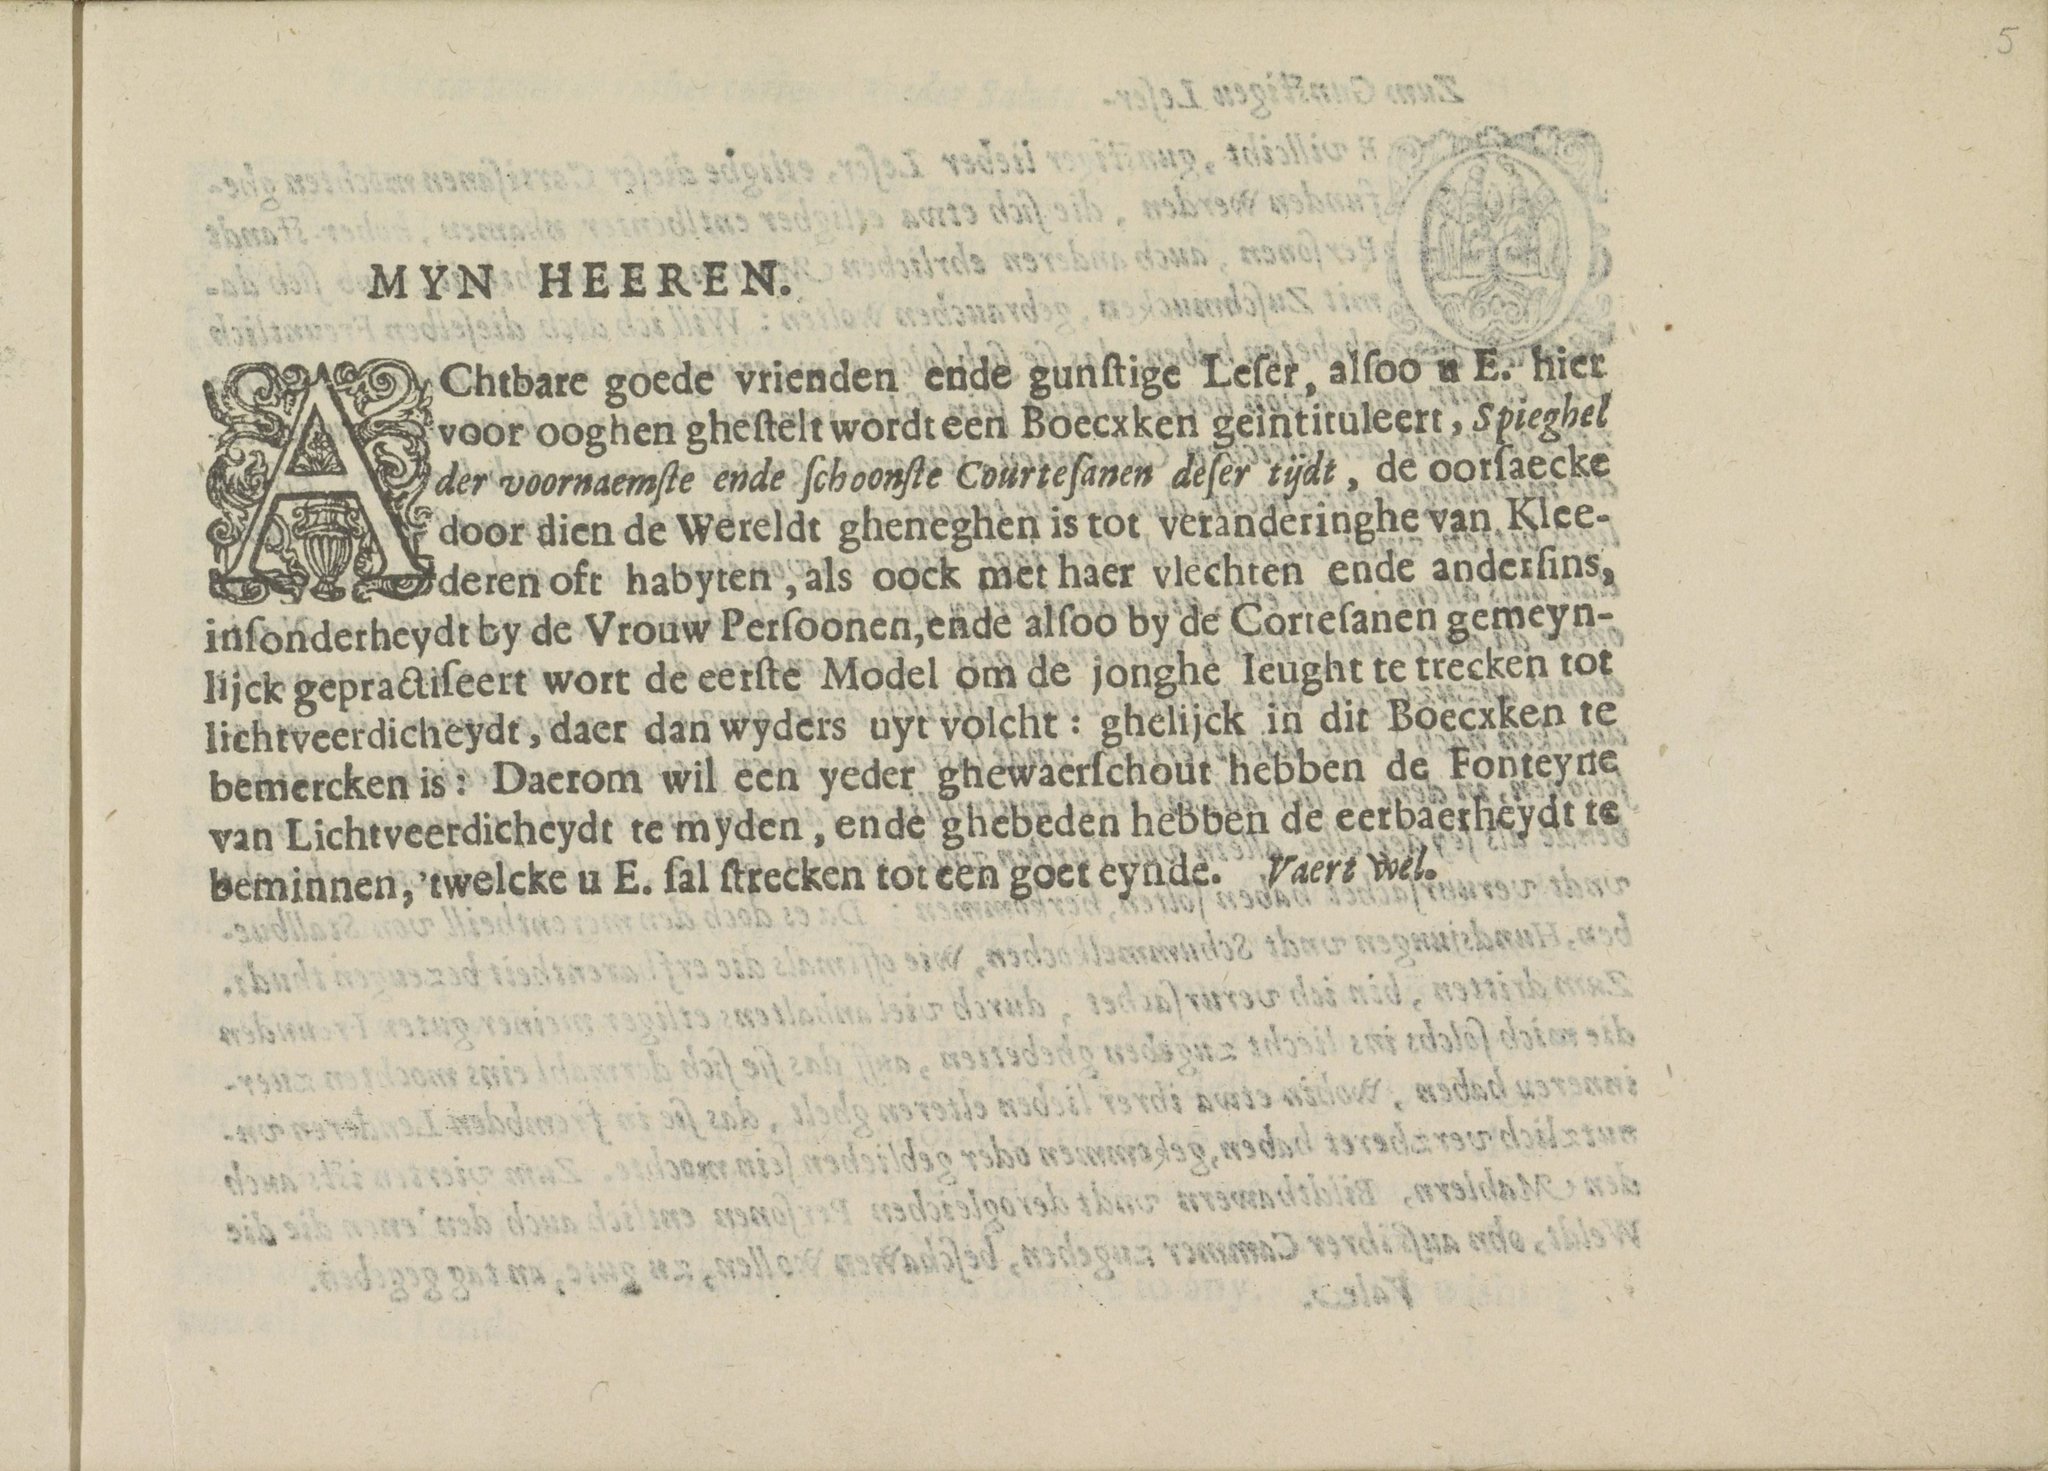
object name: album leaf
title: Miroir des plus belles courtisanes de ce temps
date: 1635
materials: paper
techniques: letterpress printing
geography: utrecht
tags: initial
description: Nederlandstalig voorwoord met de aanhef: Myn Heeren. De tekst vangt aan met een gedecoreerde initiaal A. Het blad maakt deel uit van een album.